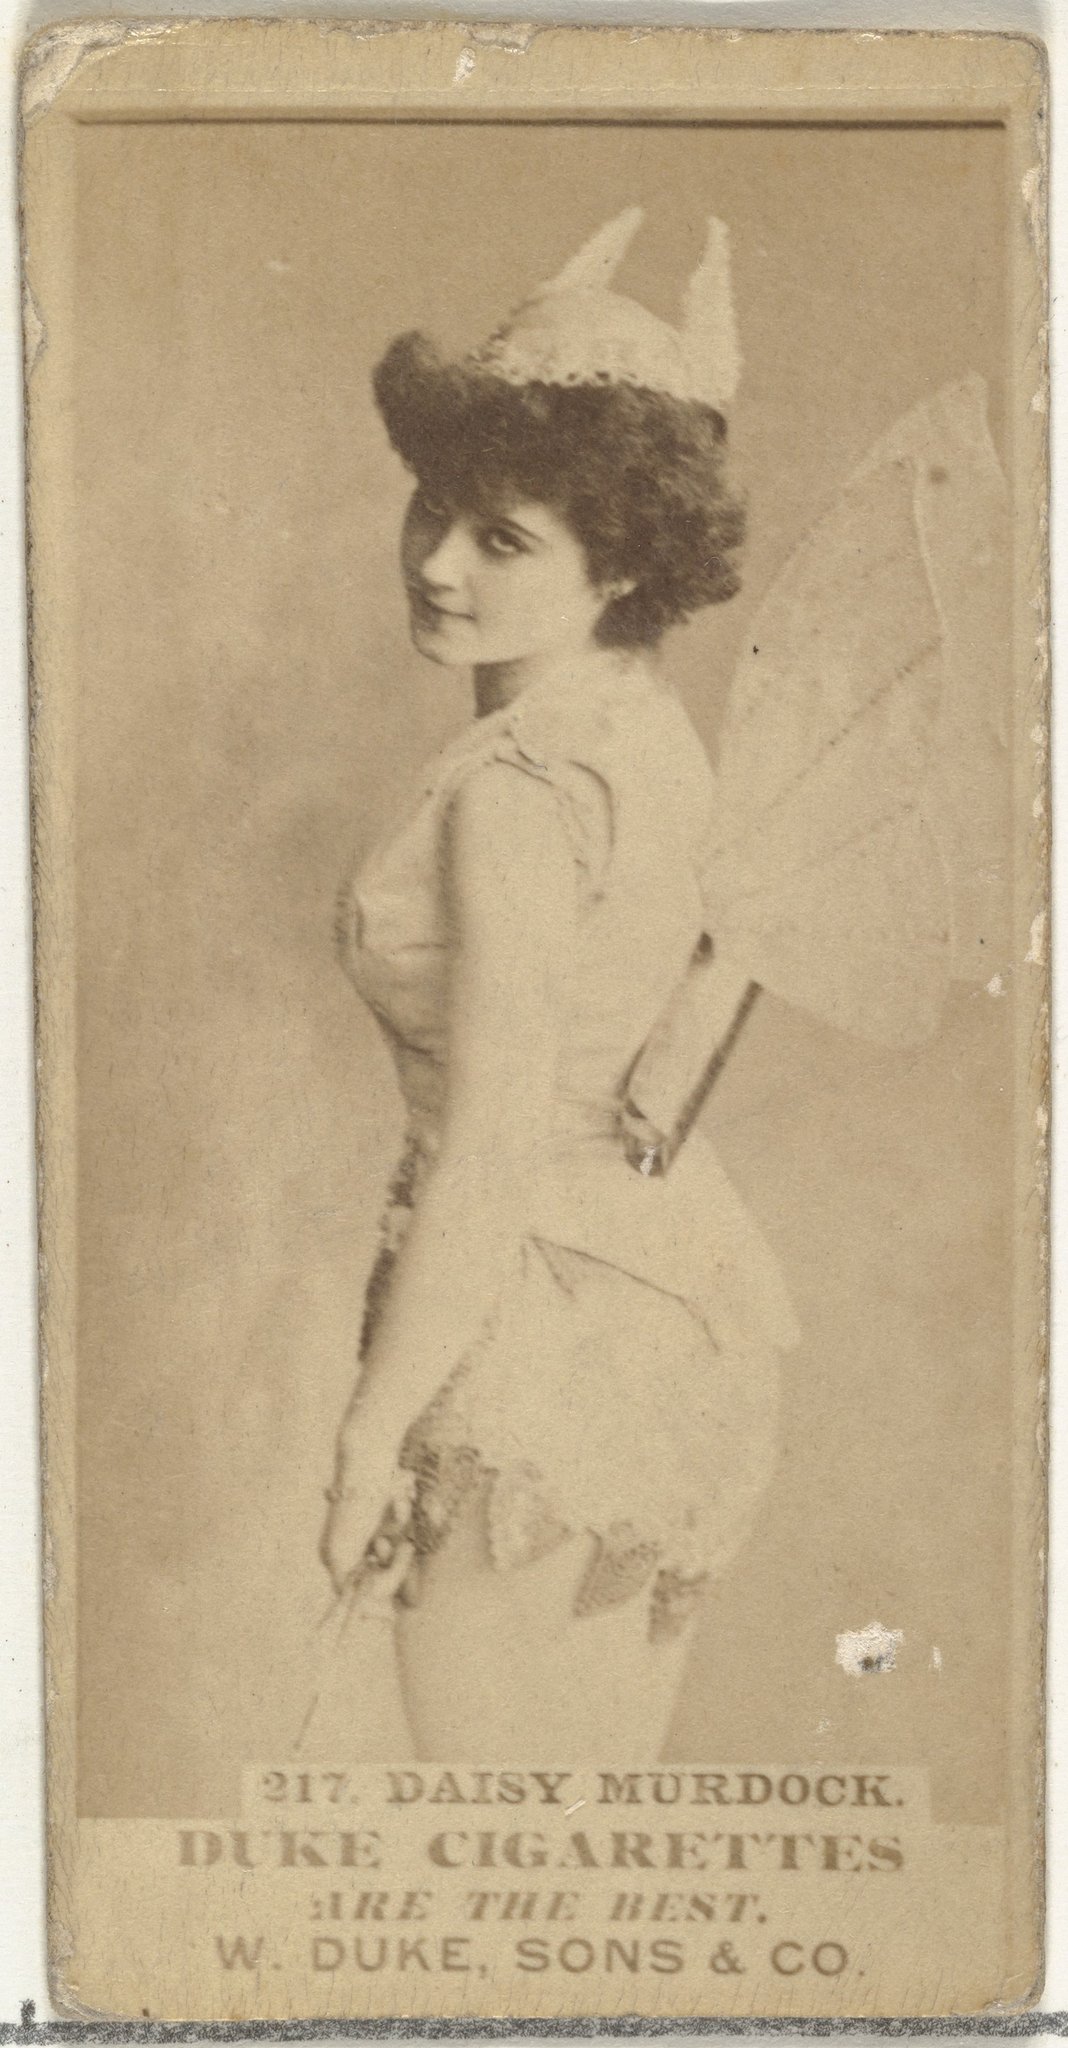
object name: photograph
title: Card Number 217, Daisy Murdoch, from the Actors and Actresses series (N145-7) issued by Duke Sons & Co. to promote Duke Cigarettes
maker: w. duke, sons & co.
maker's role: publisher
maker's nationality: american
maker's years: 1870-1920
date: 1880-1889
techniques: albumen silver print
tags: portraits,women,actresses